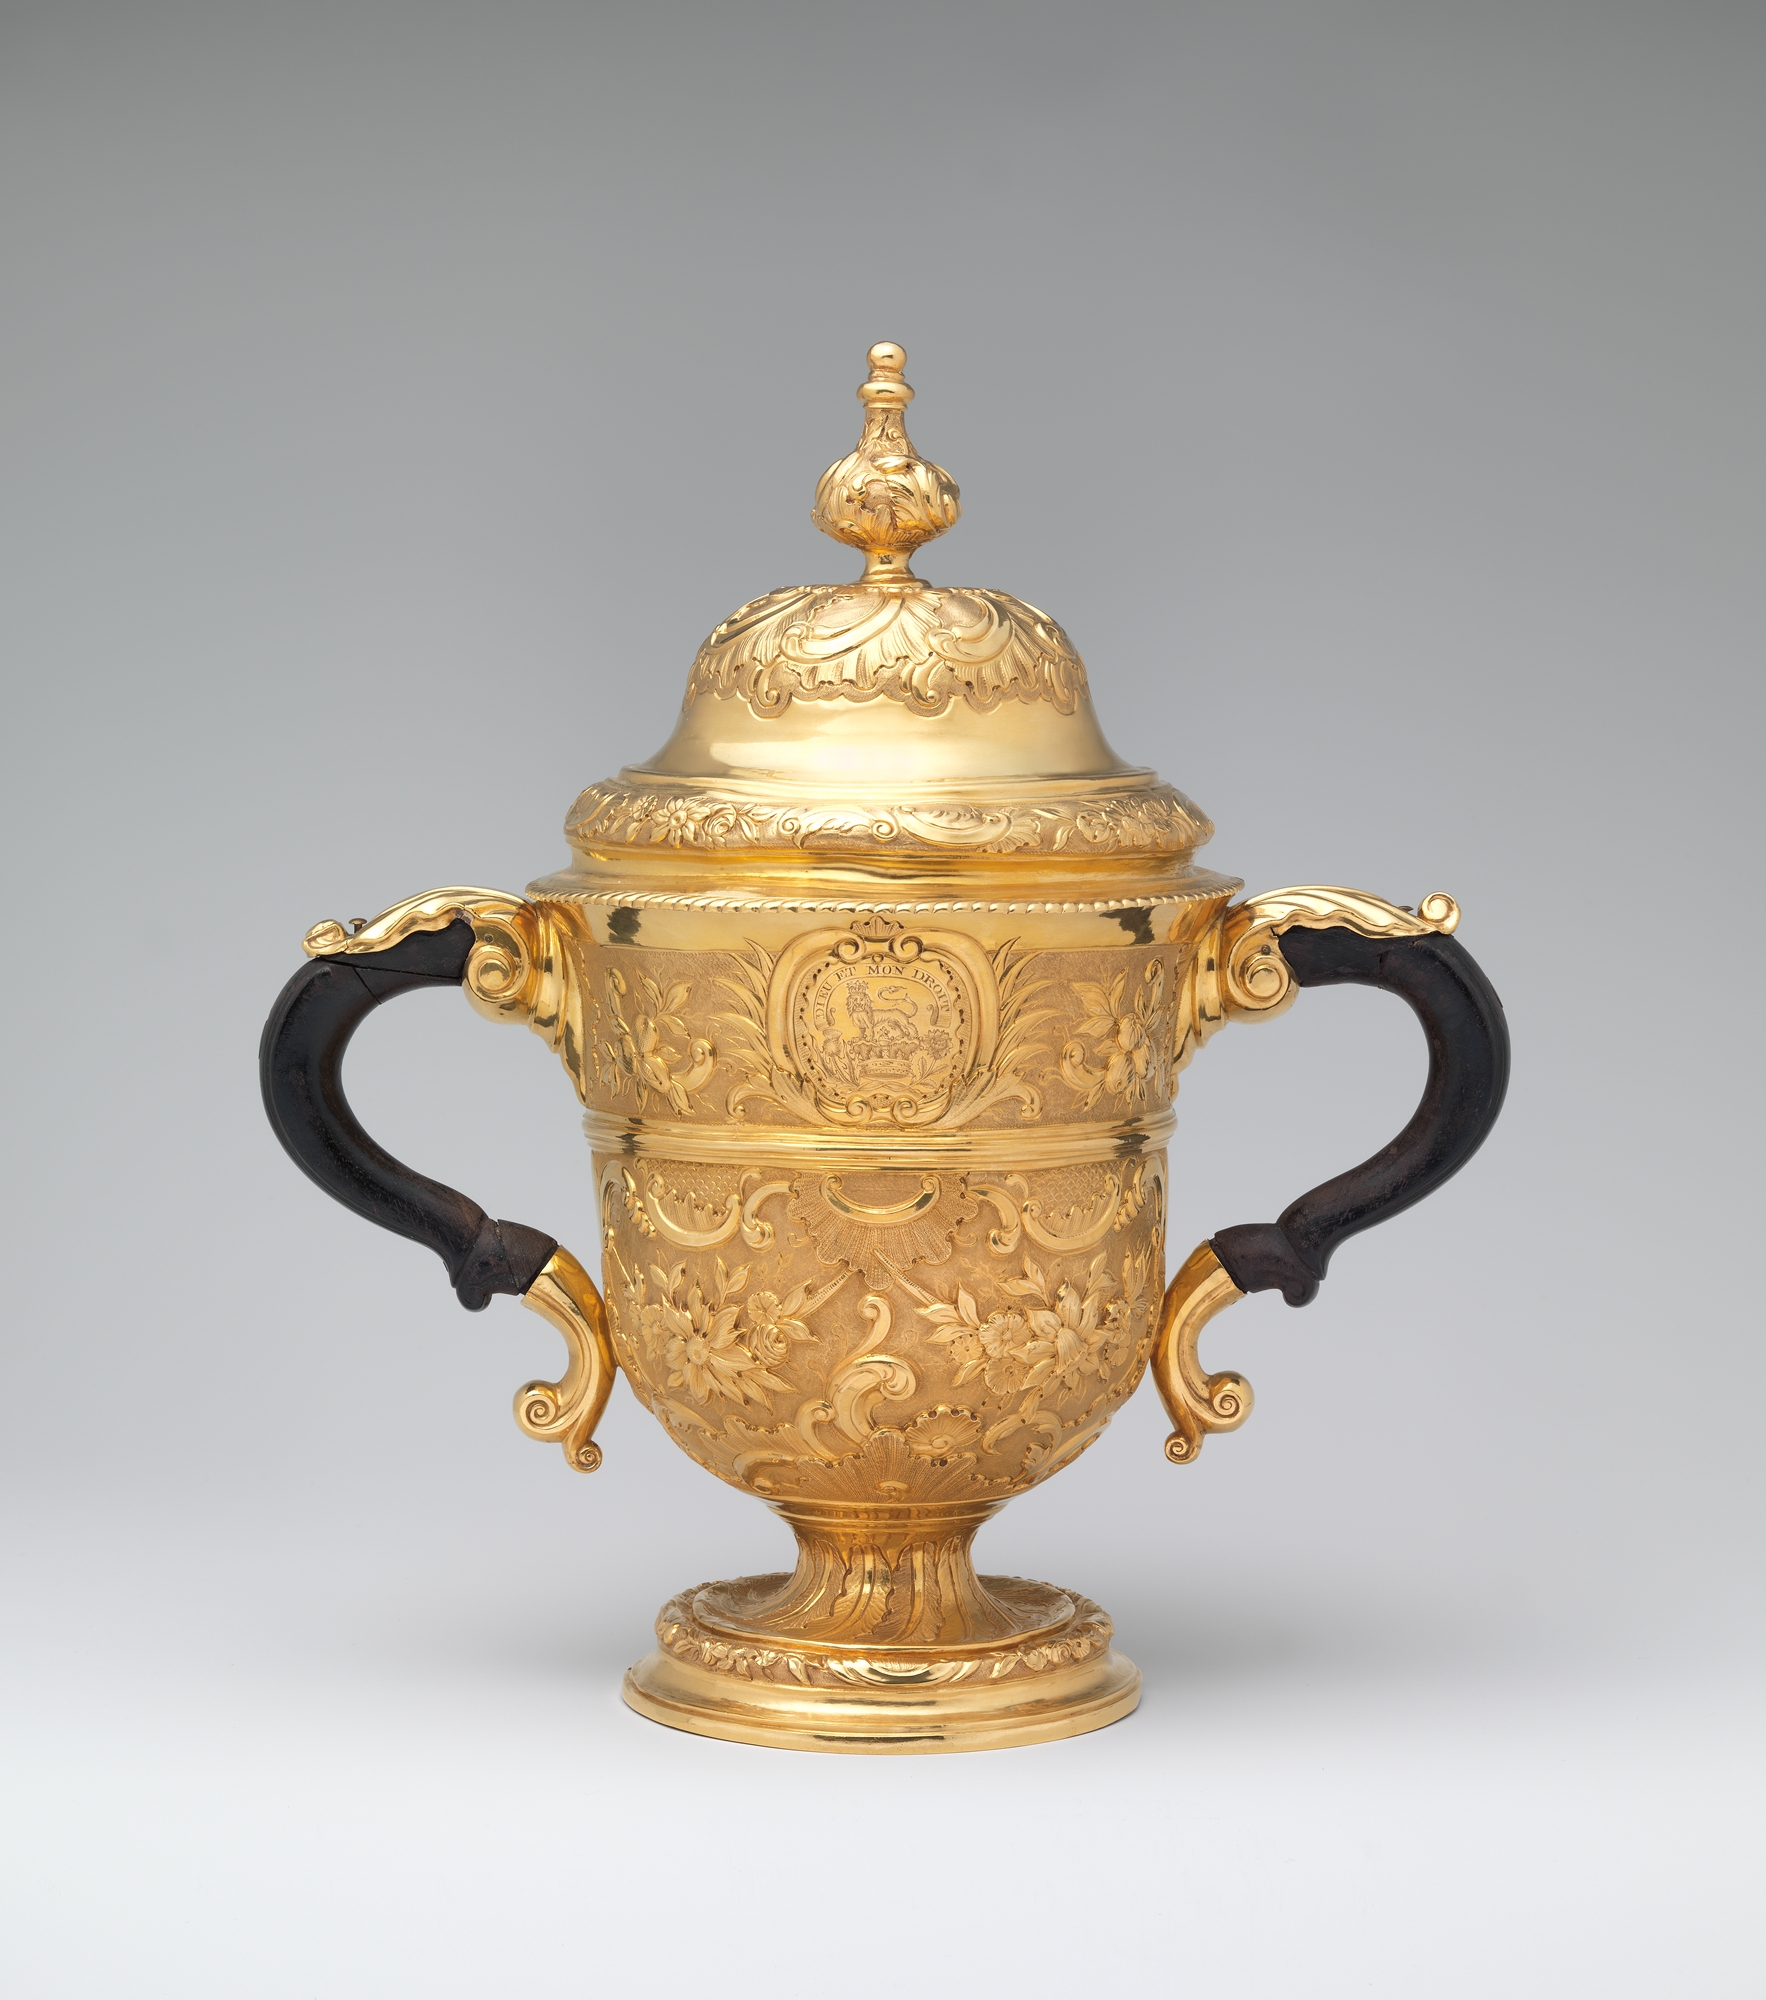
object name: cup with cover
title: Two-handled cup with cover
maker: william gilchrist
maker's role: maker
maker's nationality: scottish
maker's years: 1736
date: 1752-1753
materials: wood, gold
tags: flowers,coat of arms,trophies